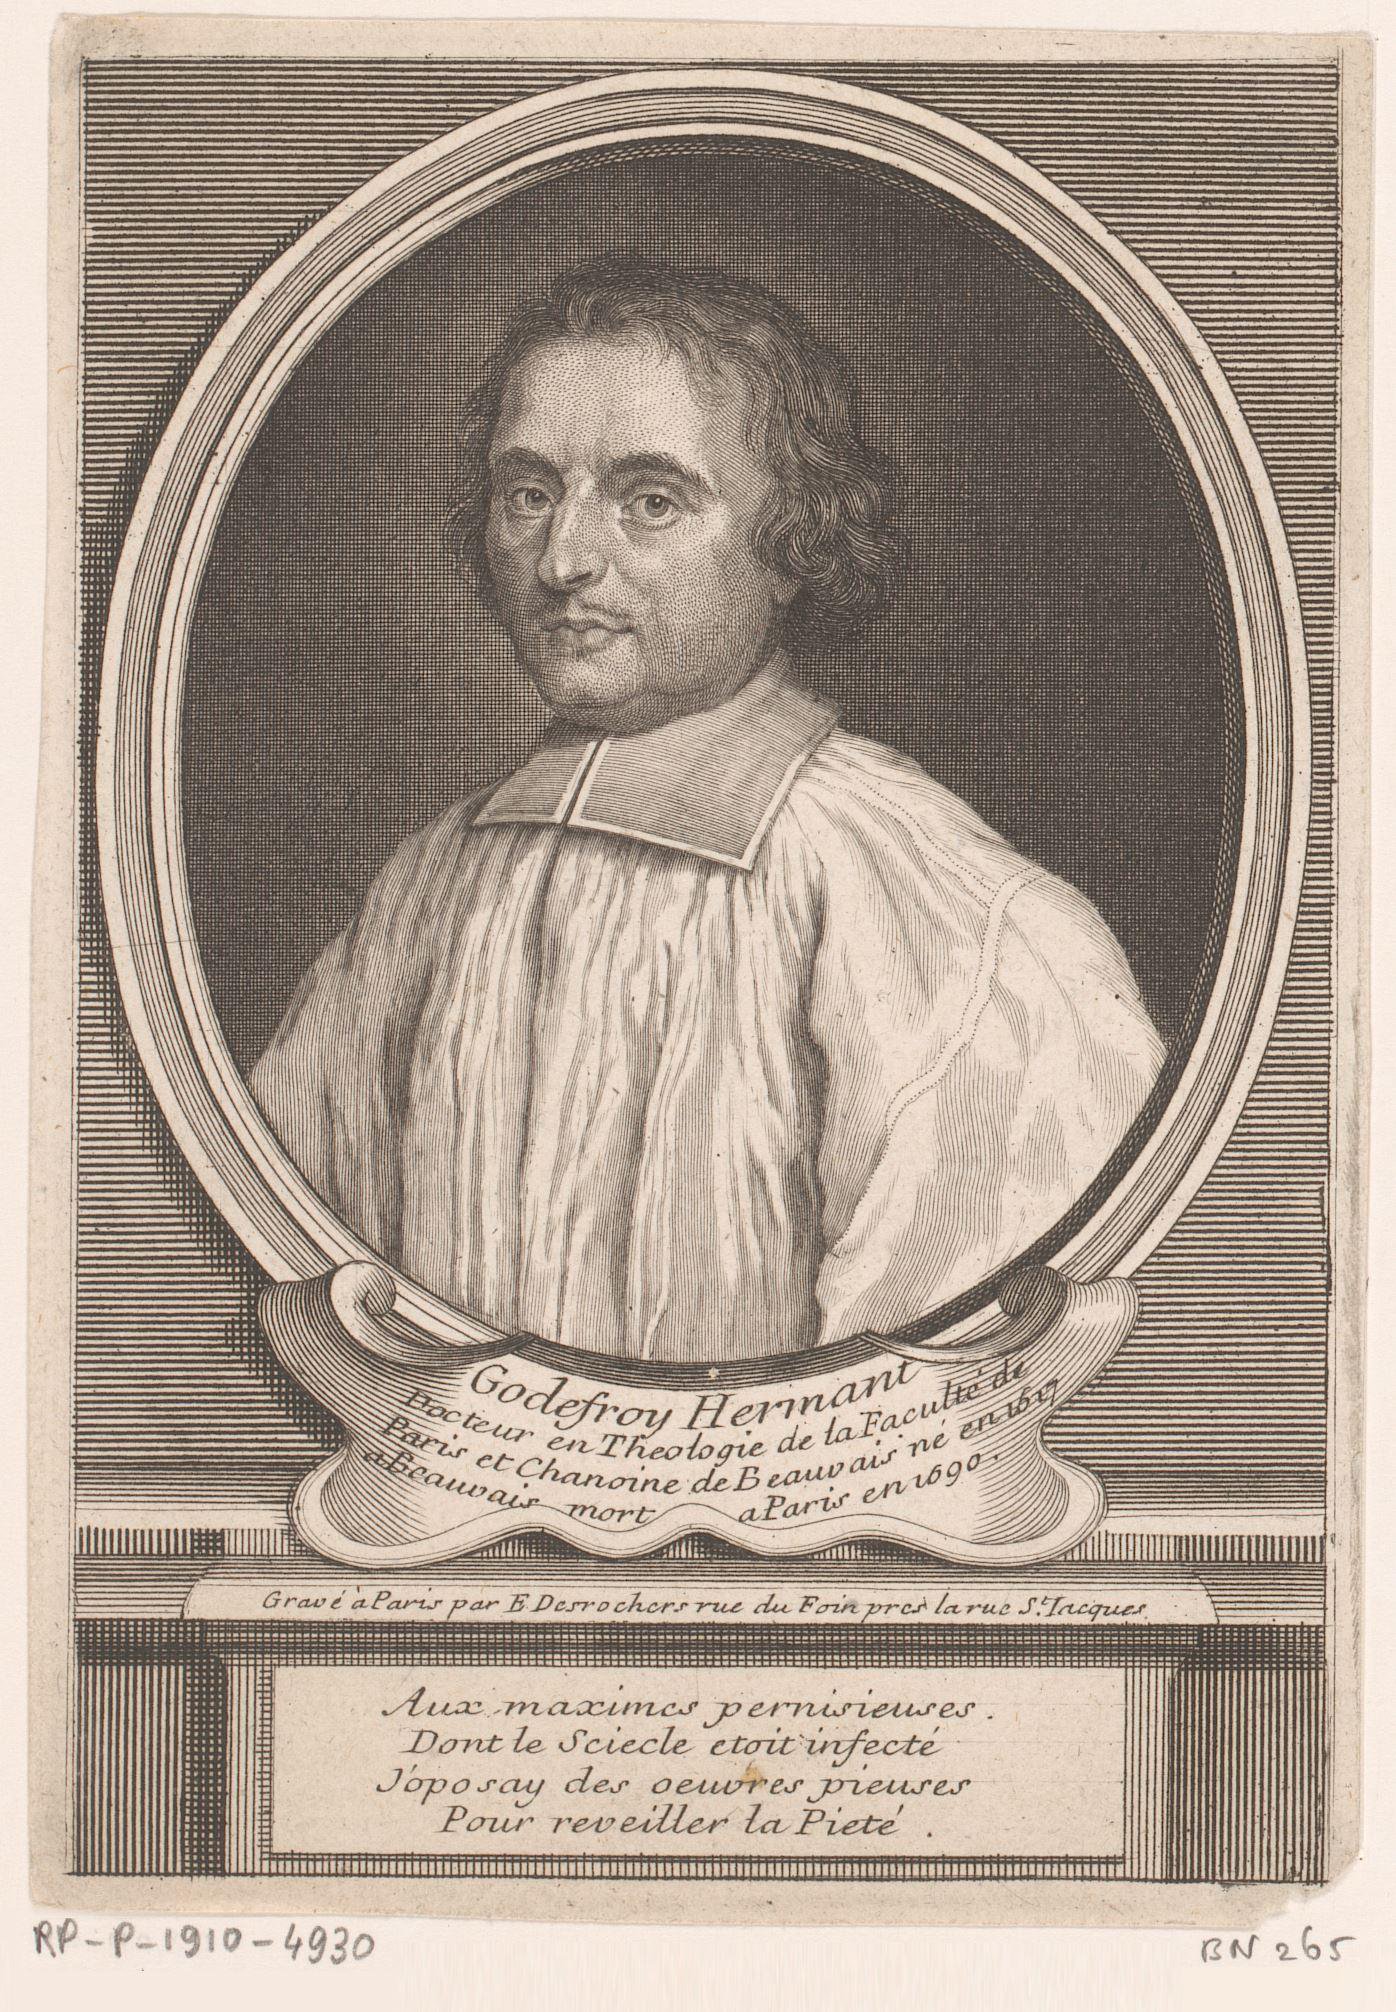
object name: print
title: Recueil de portraits (...)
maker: étienne desrochers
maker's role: print maker, publisher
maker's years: 1668-1741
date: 1726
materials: paper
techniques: engraving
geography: paris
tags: beauvais, priest, historical persons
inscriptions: collector's mark: Lugt 2228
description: Behoort waarschijnlijk tot een serie portretten, grotendeels door Etienne Desrochers, getiteld: 'Recueil de portraits de personnes qui se sont distinguées tant dans les Armes que dans Belles-Lettres et les Arts, comme aussi la famille royale de France et autres cours étrangères'. De serie werd initieel uitgegeven door Desrochers en aangekondigd in 'Mercure' in mei 1726, p. 985. Echter was Desrochers reeds enkele jaren eerder begonnen met het uitgeven van de serie. Na de dood van Desrochers werd de serie voortgezet door Gilles Edme Petit. Een latere staat werd uitgegeven door Jean François Daumont in Parijs.